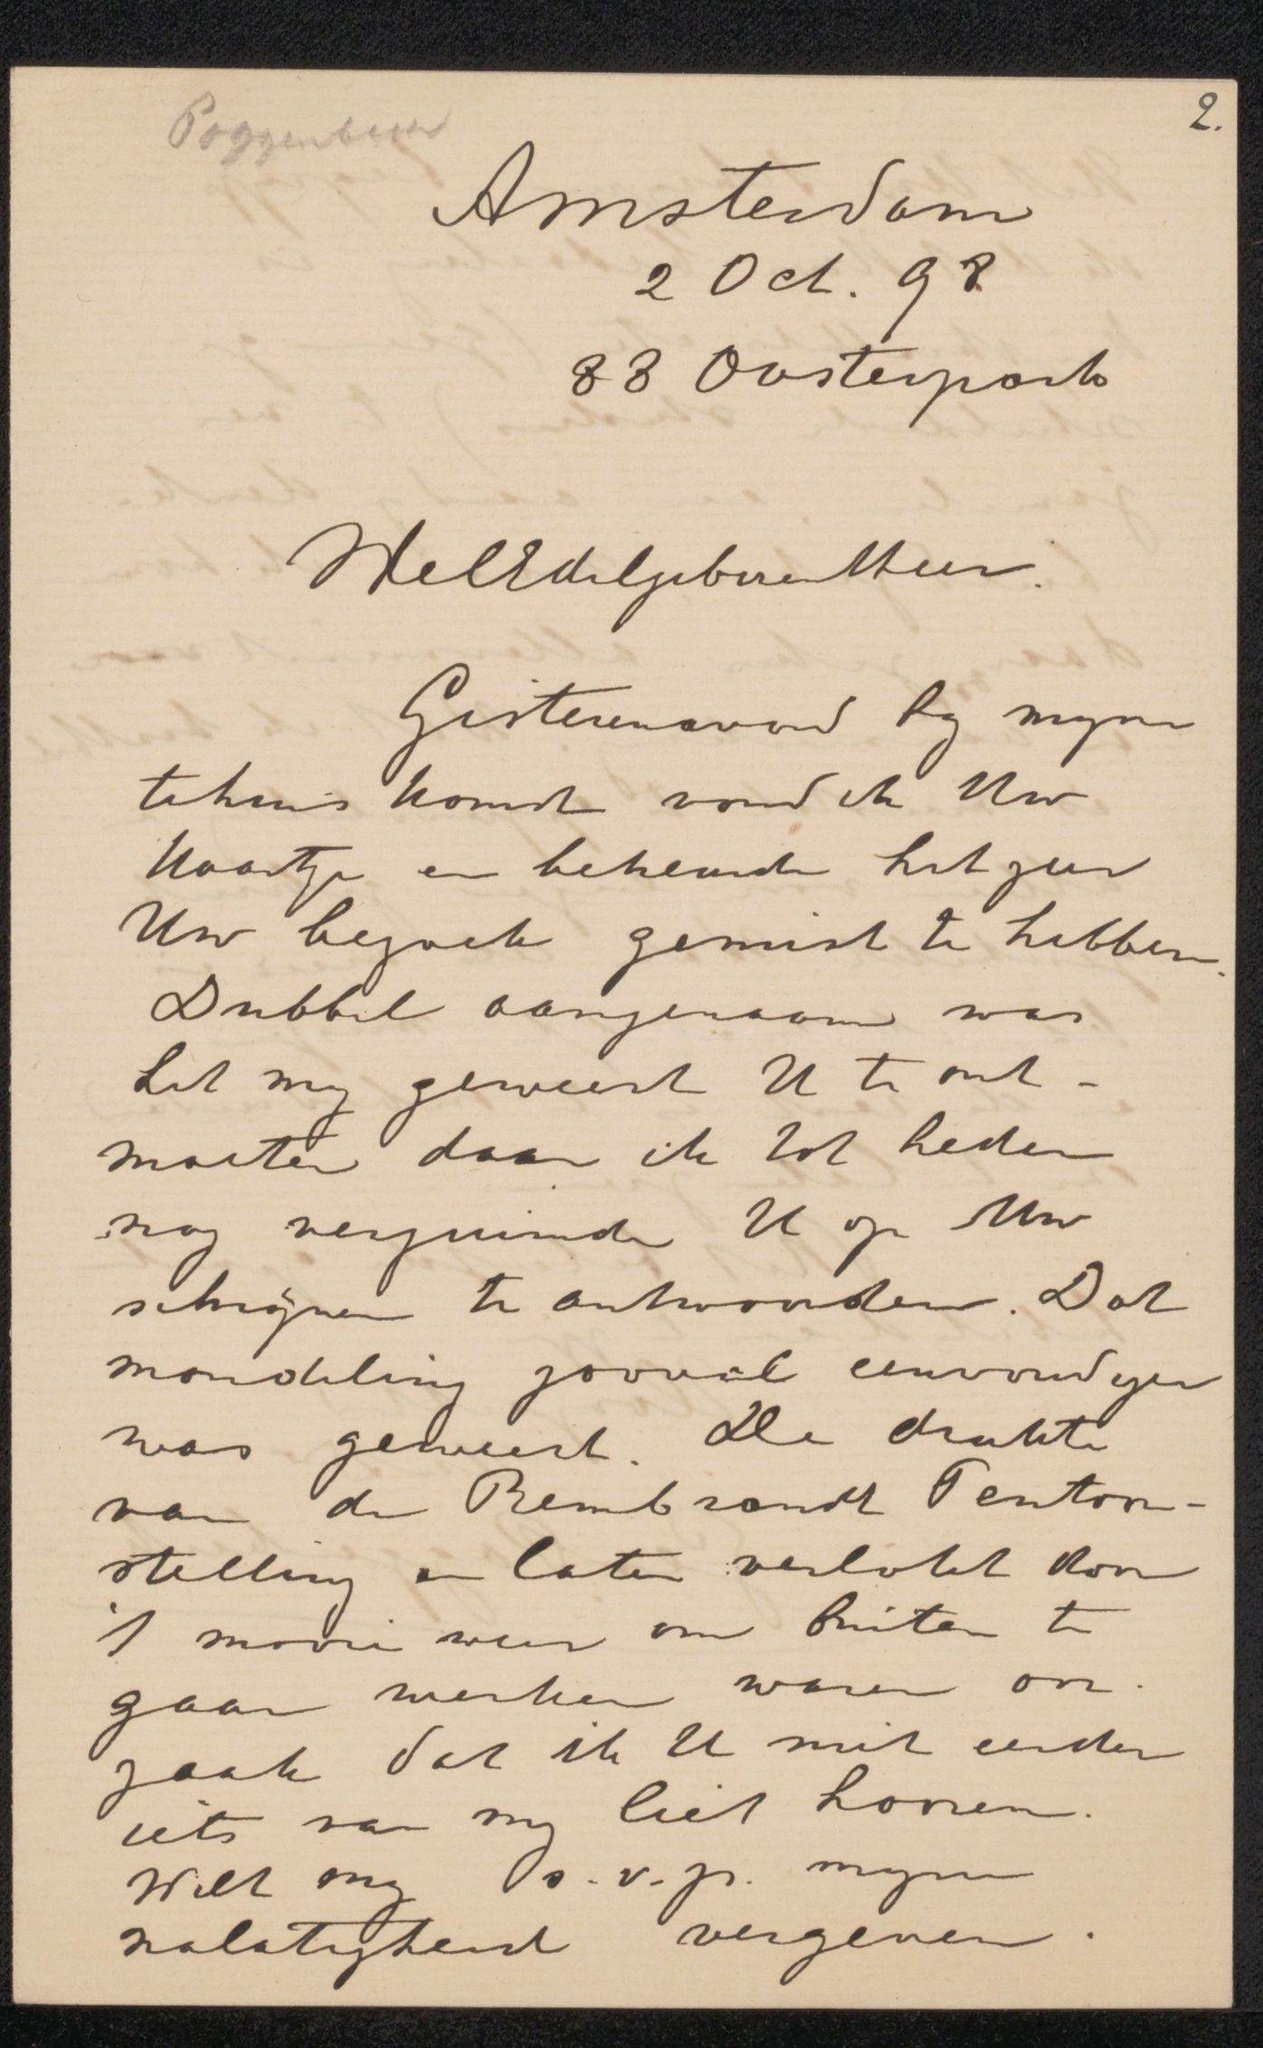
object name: letter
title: Brief aan Pieter Haverkorn van Rijsewijk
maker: geo poggenbeek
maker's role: draughtsman, painter, print maker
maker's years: 1853-1903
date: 1898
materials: ink, paper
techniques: pen, writing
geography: amsterdam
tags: pieter haverkorn van rijsewijk, drawing, exhibition ~ art